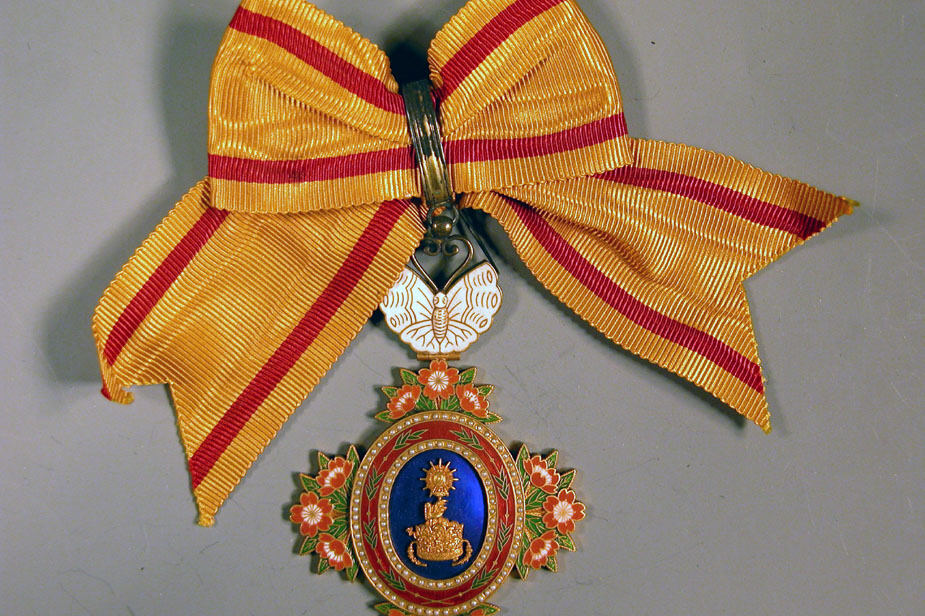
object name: medal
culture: japanese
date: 1867-1900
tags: flowers